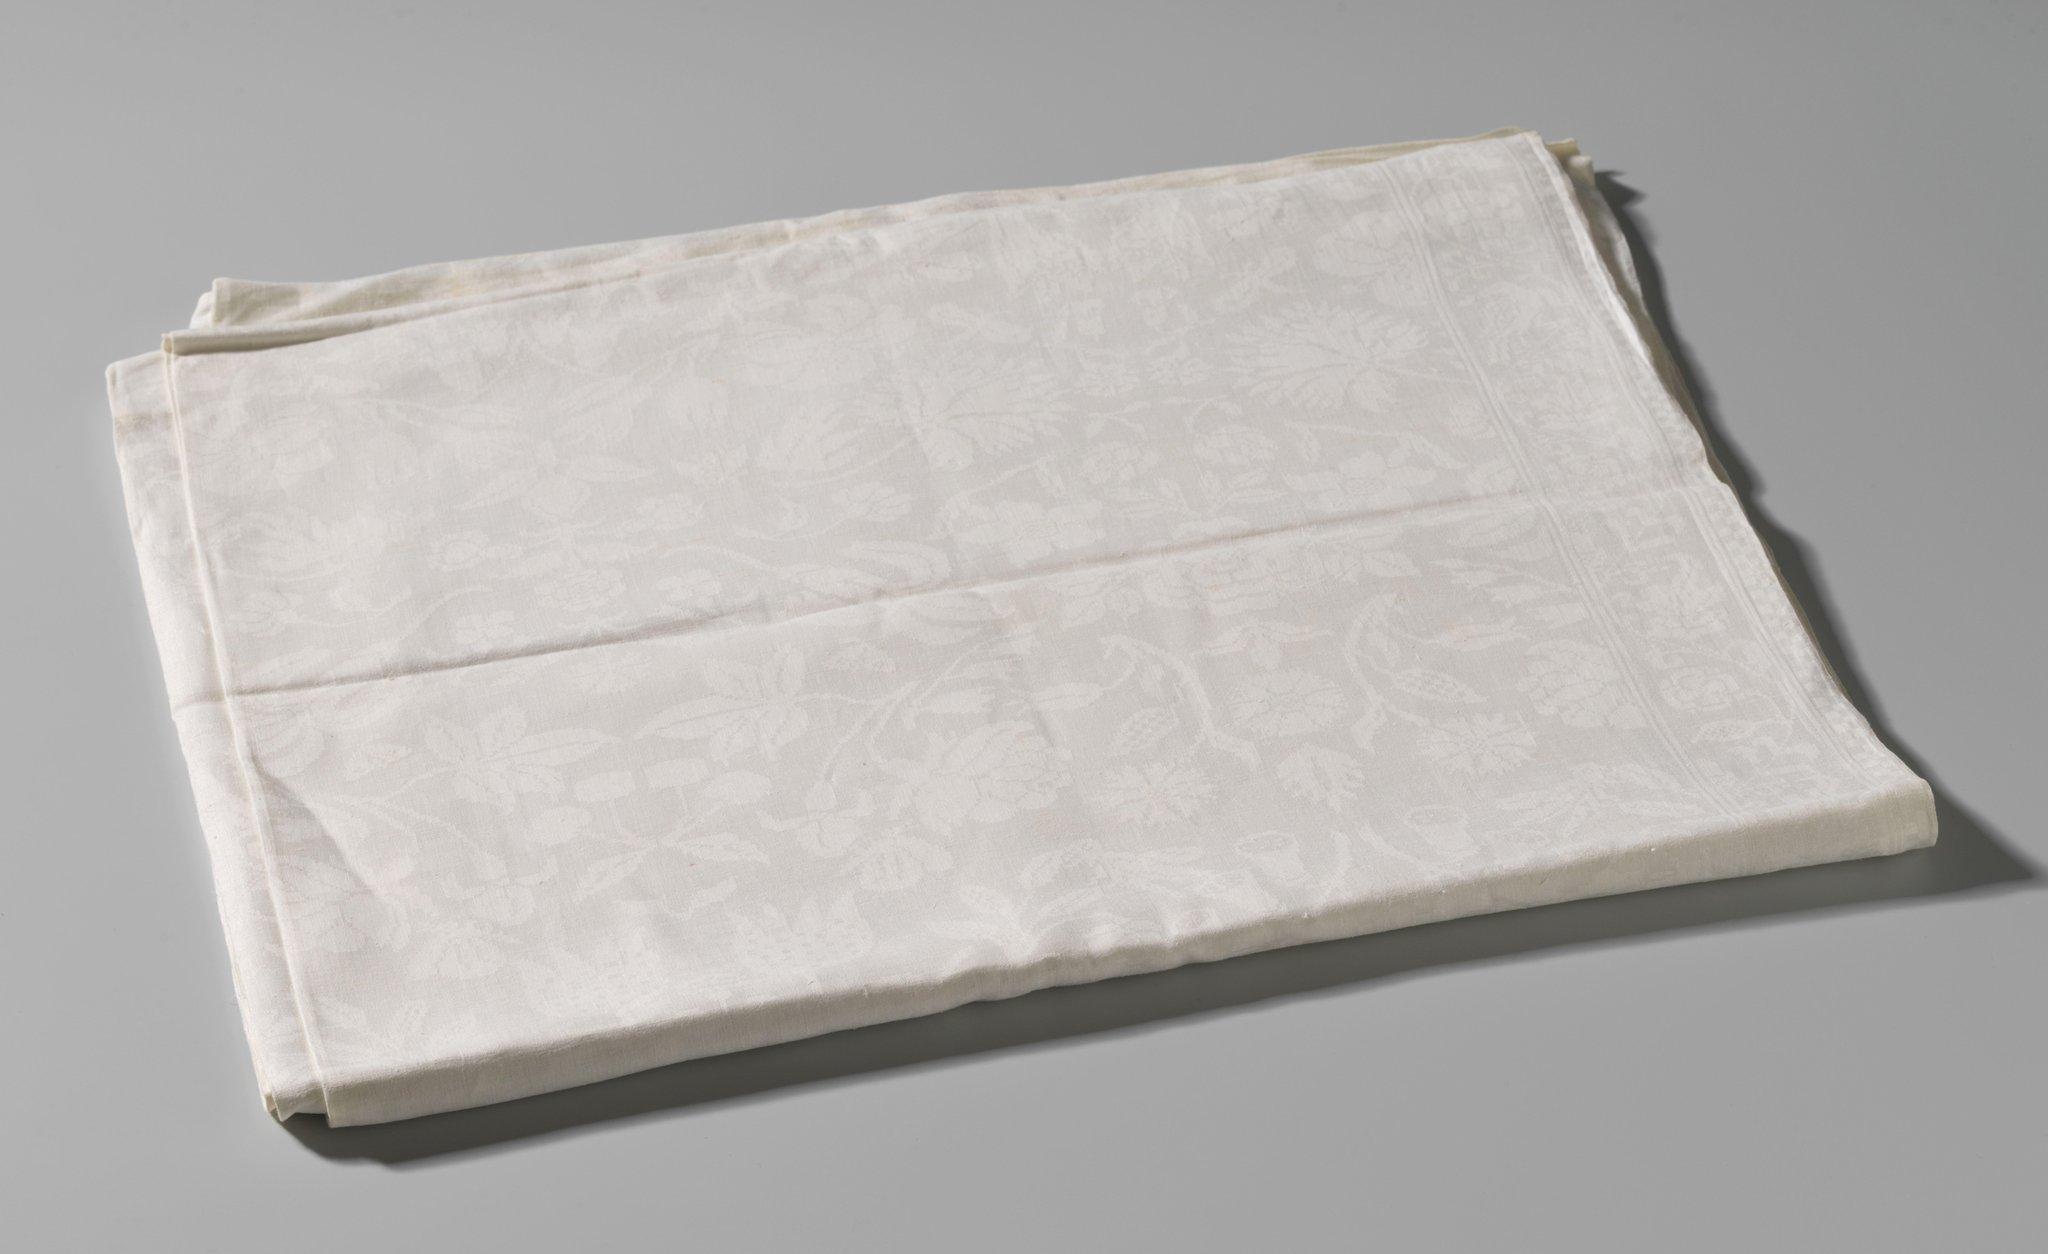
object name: tablecloth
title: Tafellaken van wit linnendamast met patroon van gestrooide bloemen, kersen en insecten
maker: Anonymous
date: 1600-1699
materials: linen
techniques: damask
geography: netherlands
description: Tafellaken van wit linnendamast met patroon van gestrooide bloemen, kersen en insecten.